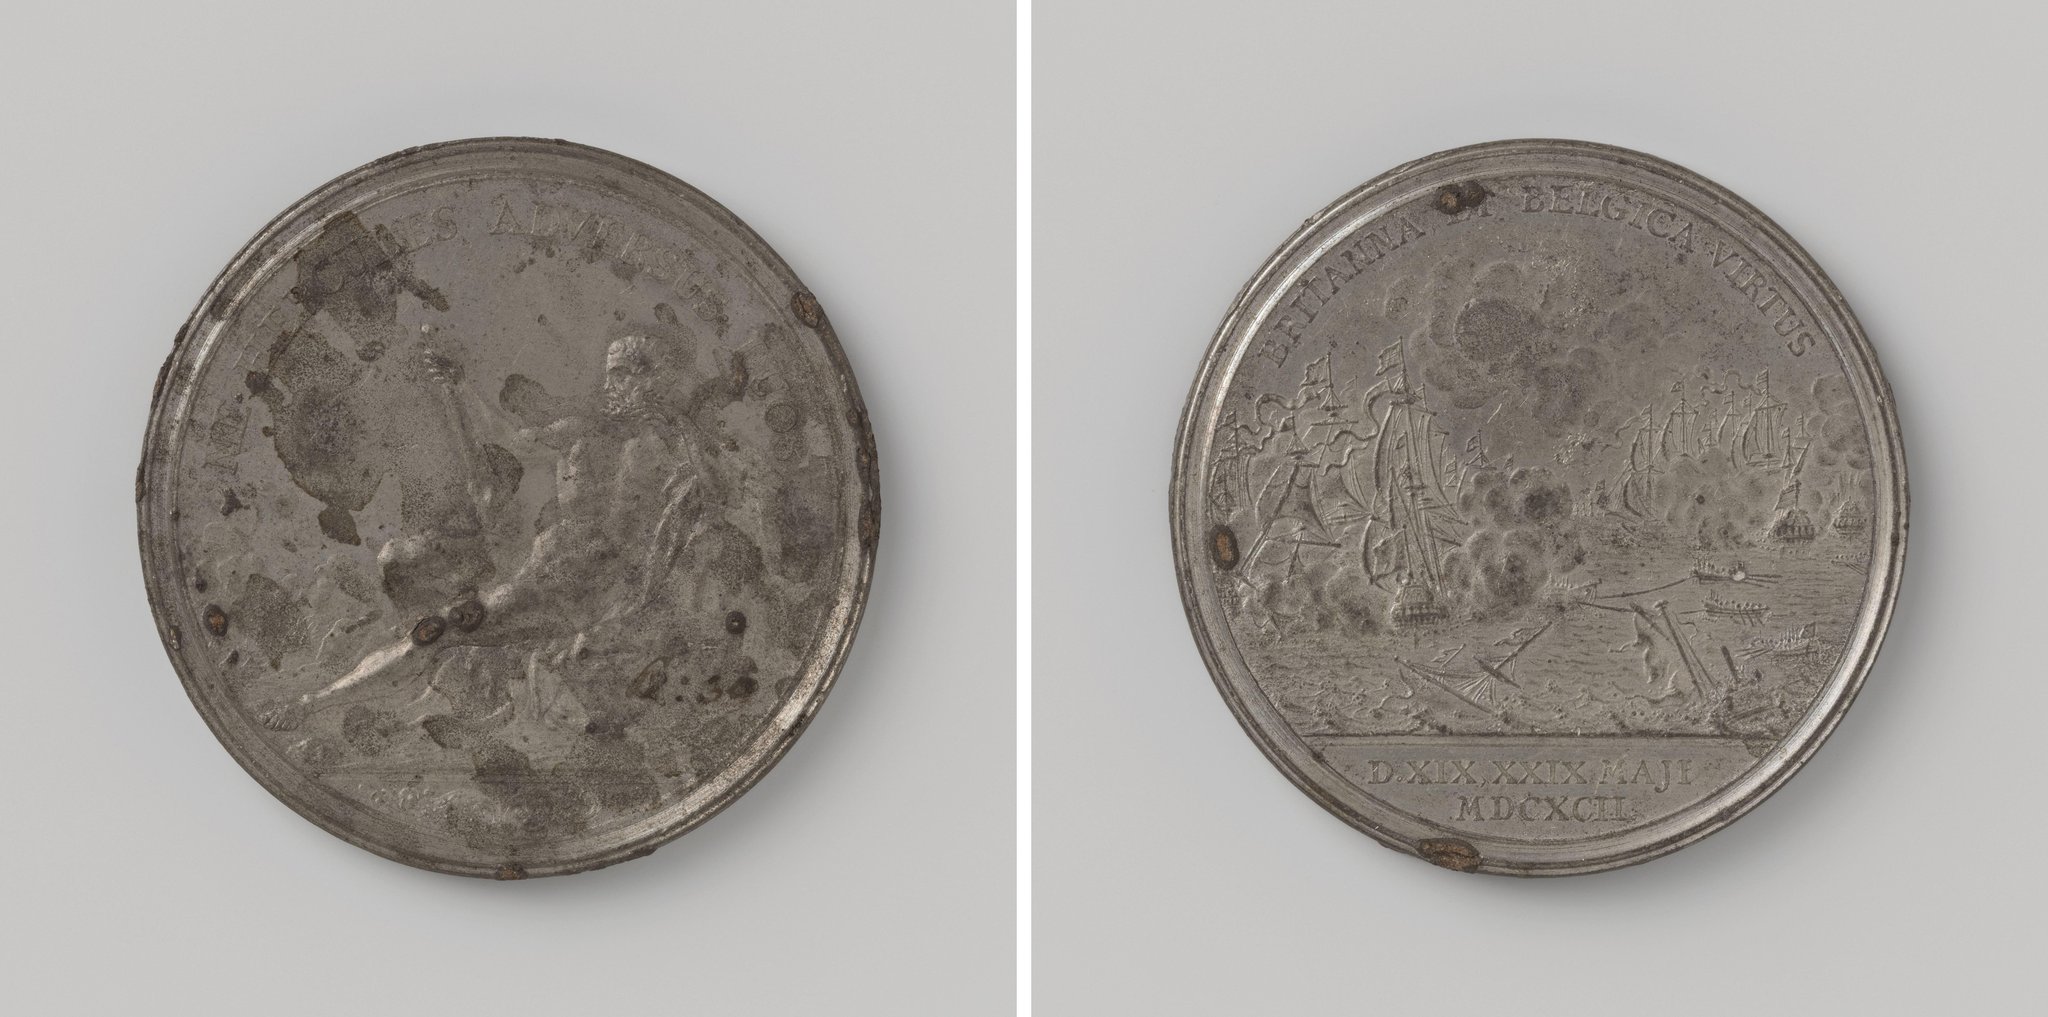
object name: history medal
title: Zeeslag bij Kaap La Hogue, de Fransen verslagen door de vloot van Engeland en Holland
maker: jan smeltzing (i)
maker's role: modelleur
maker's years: 1656-1693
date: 1692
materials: tin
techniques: striking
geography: leiden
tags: the hague, william iii (prince of orange and king of england, scotland, and ireland)